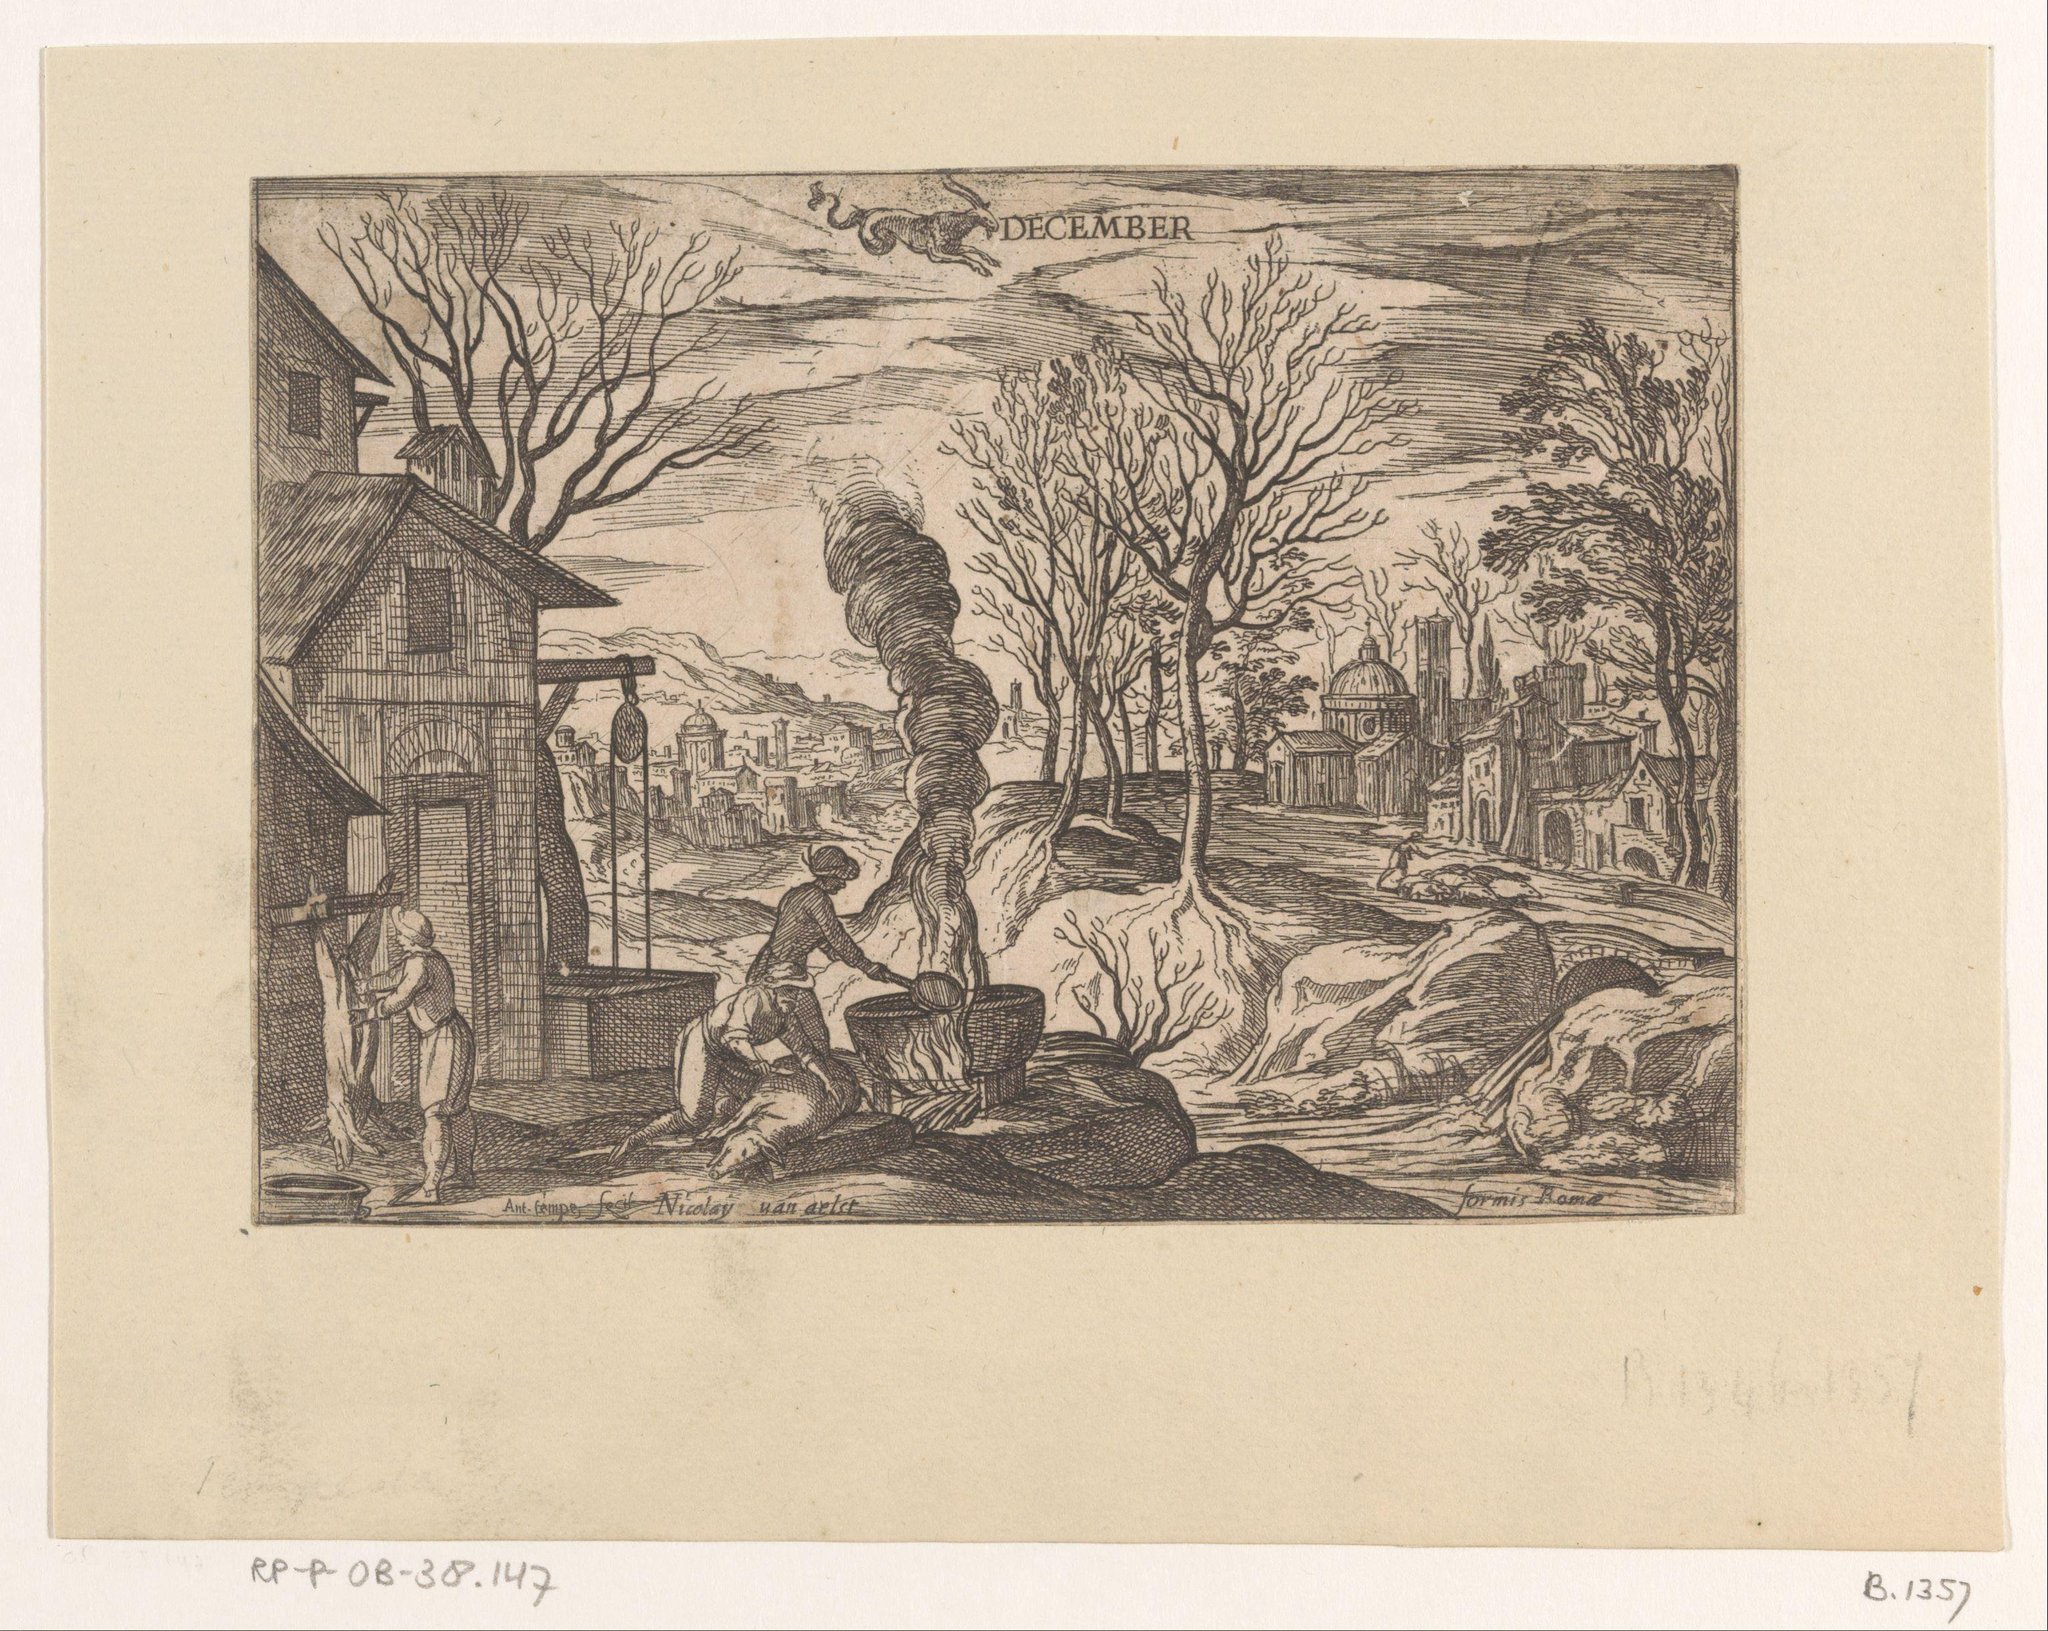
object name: print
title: December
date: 1575-1613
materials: paper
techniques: etching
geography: italy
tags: landscape symbolizing december, butcher, slaughterman, capricorn (zodiacal sign of december)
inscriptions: collector's mark: Lugt 240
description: Landschap dat de maand december verbeeldt. Landschap met mensen die een varken slachten. Midden boven het symbool voor het sterrenbeeld steenbok.